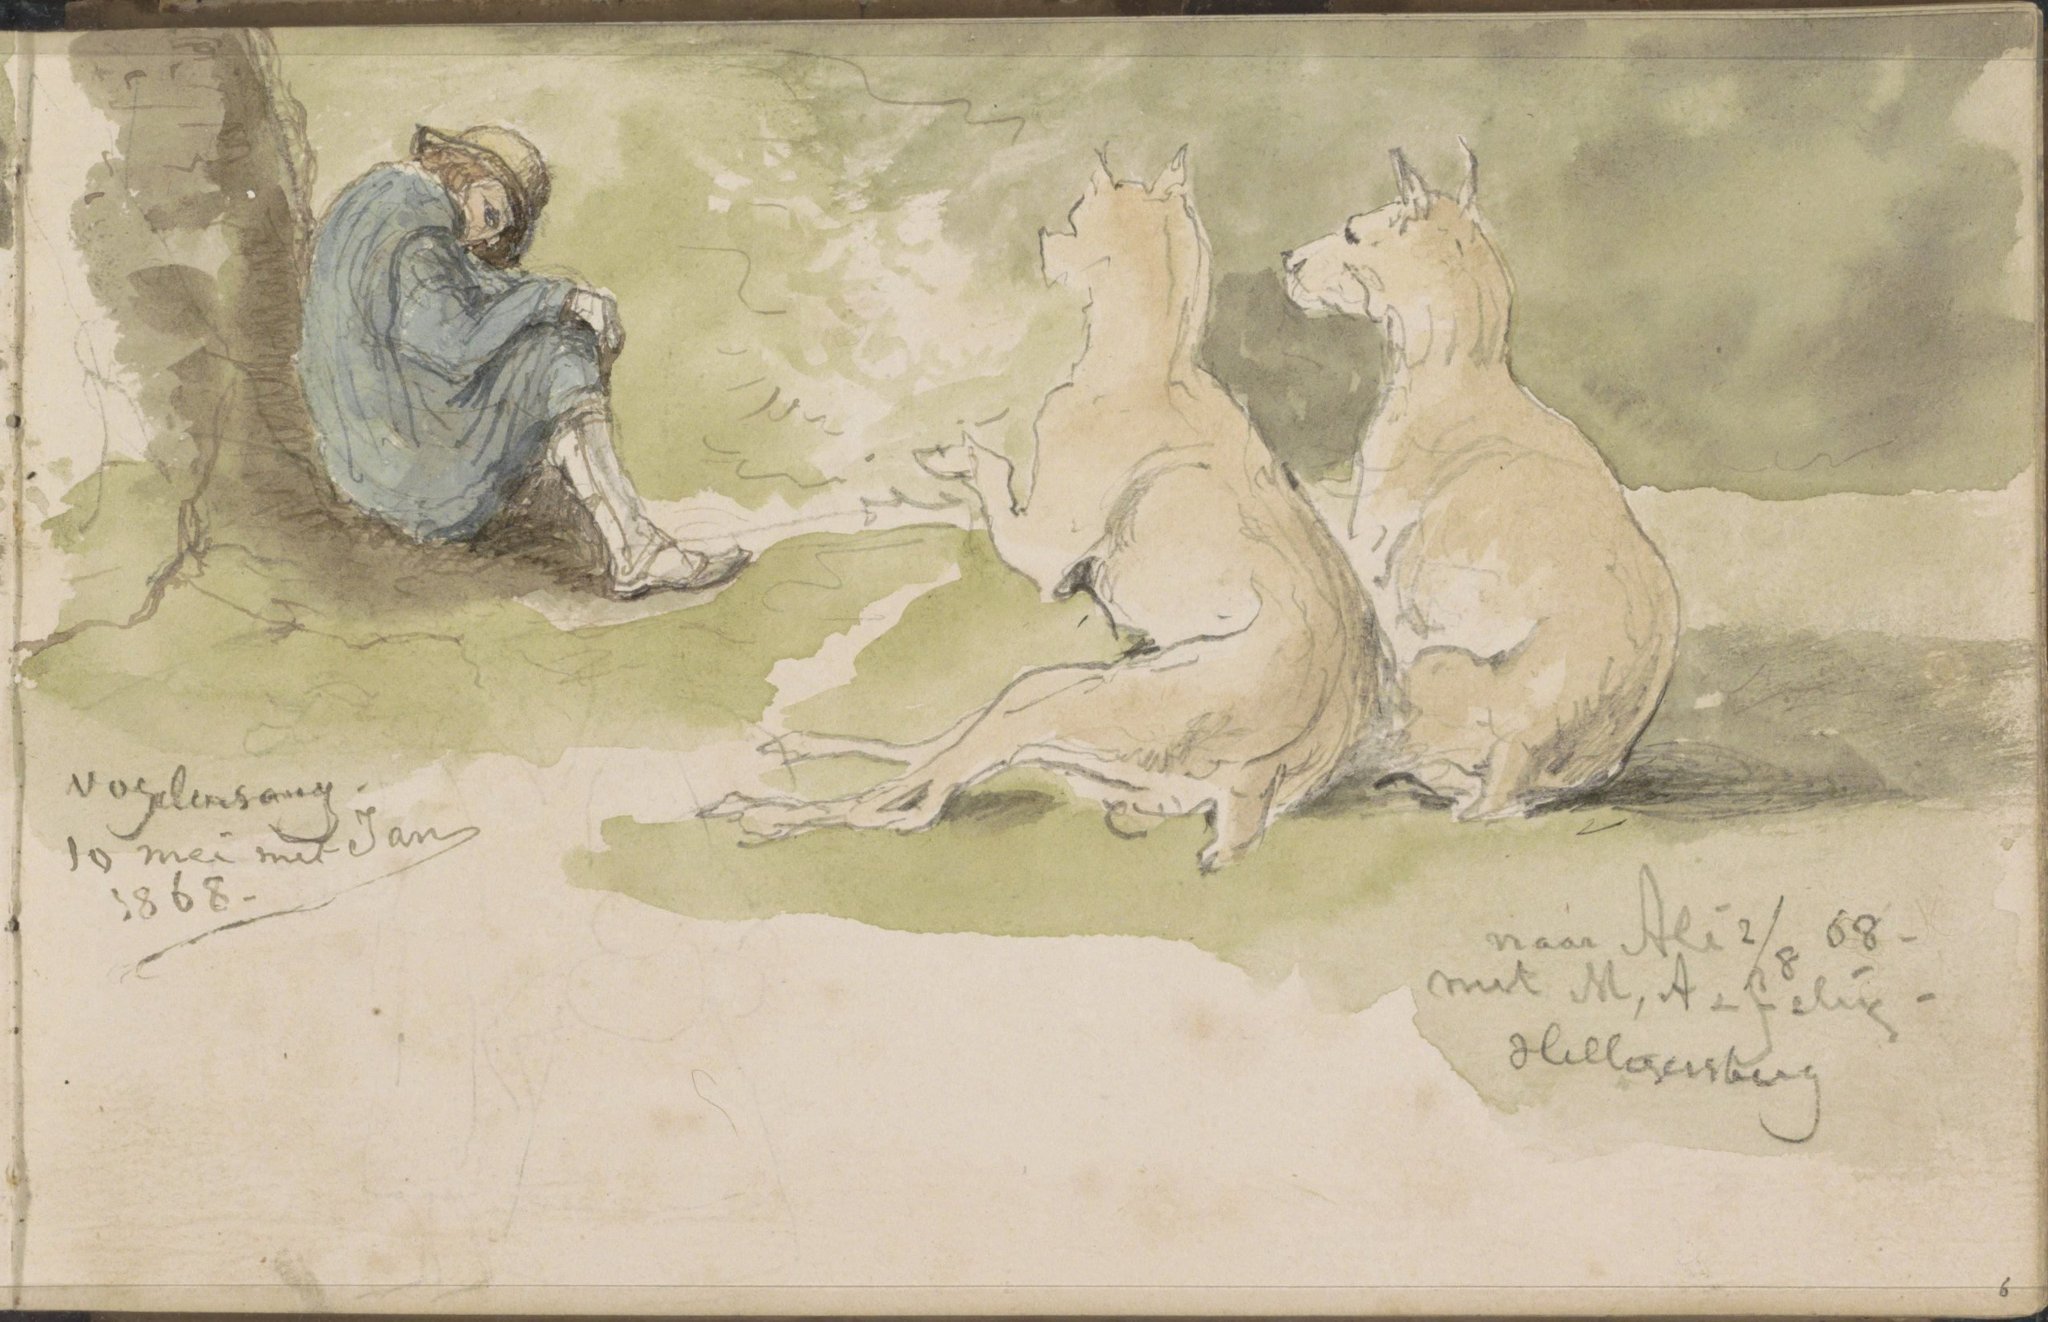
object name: sketchbook leaf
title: Man zittend tegen een boomstronk met twee honden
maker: johannes tavenraat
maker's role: draughtsman, painter, print maker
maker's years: 1809-1881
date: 1805-1868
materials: ink, paper, pencil, watercolor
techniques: brush, pen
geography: vogelenzang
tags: trees, sitting figure, dog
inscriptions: date and inscription: ‘vogelensang/ 10 mei met Jan/ 1868./ naar Ali 2/8 68./ met M, A & Felix./ Hillegersberg’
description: Blad 6 recto uit een schetsboek met 48 bladen.